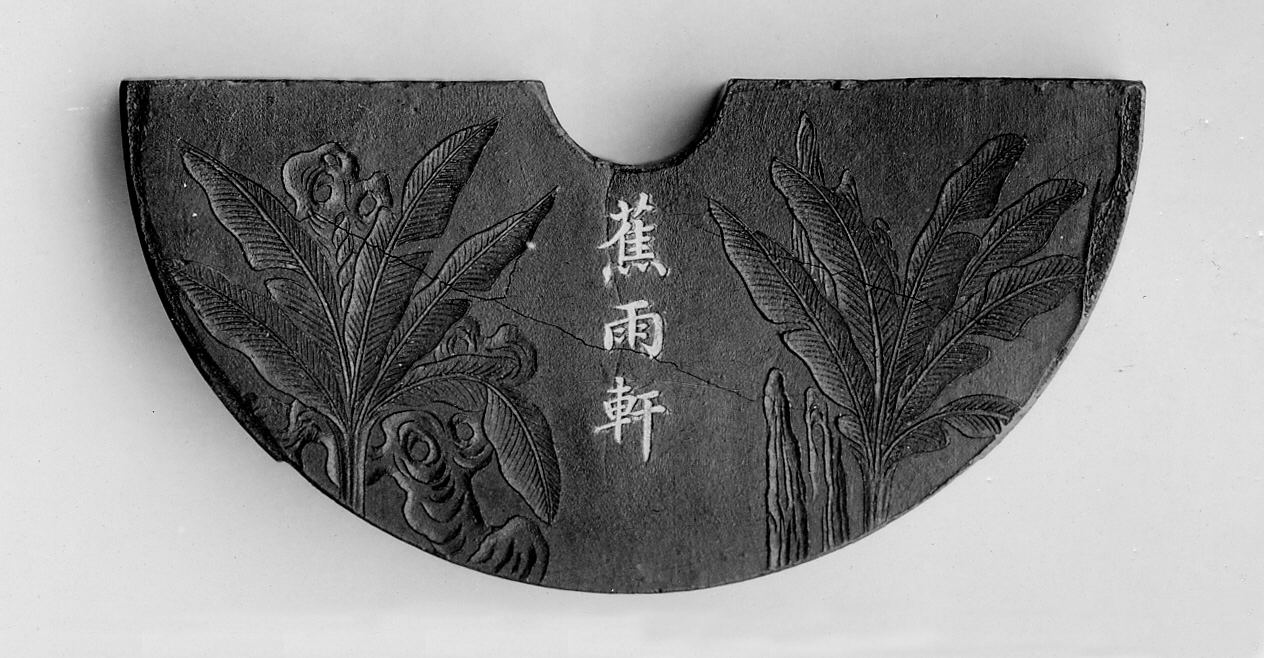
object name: ink tablet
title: Plantain Rain Pavilion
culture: chinese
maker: jian guzhai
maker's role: artist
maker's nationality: chinese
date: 1867-1933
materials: gilt, wood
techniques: bookbinding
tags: trees